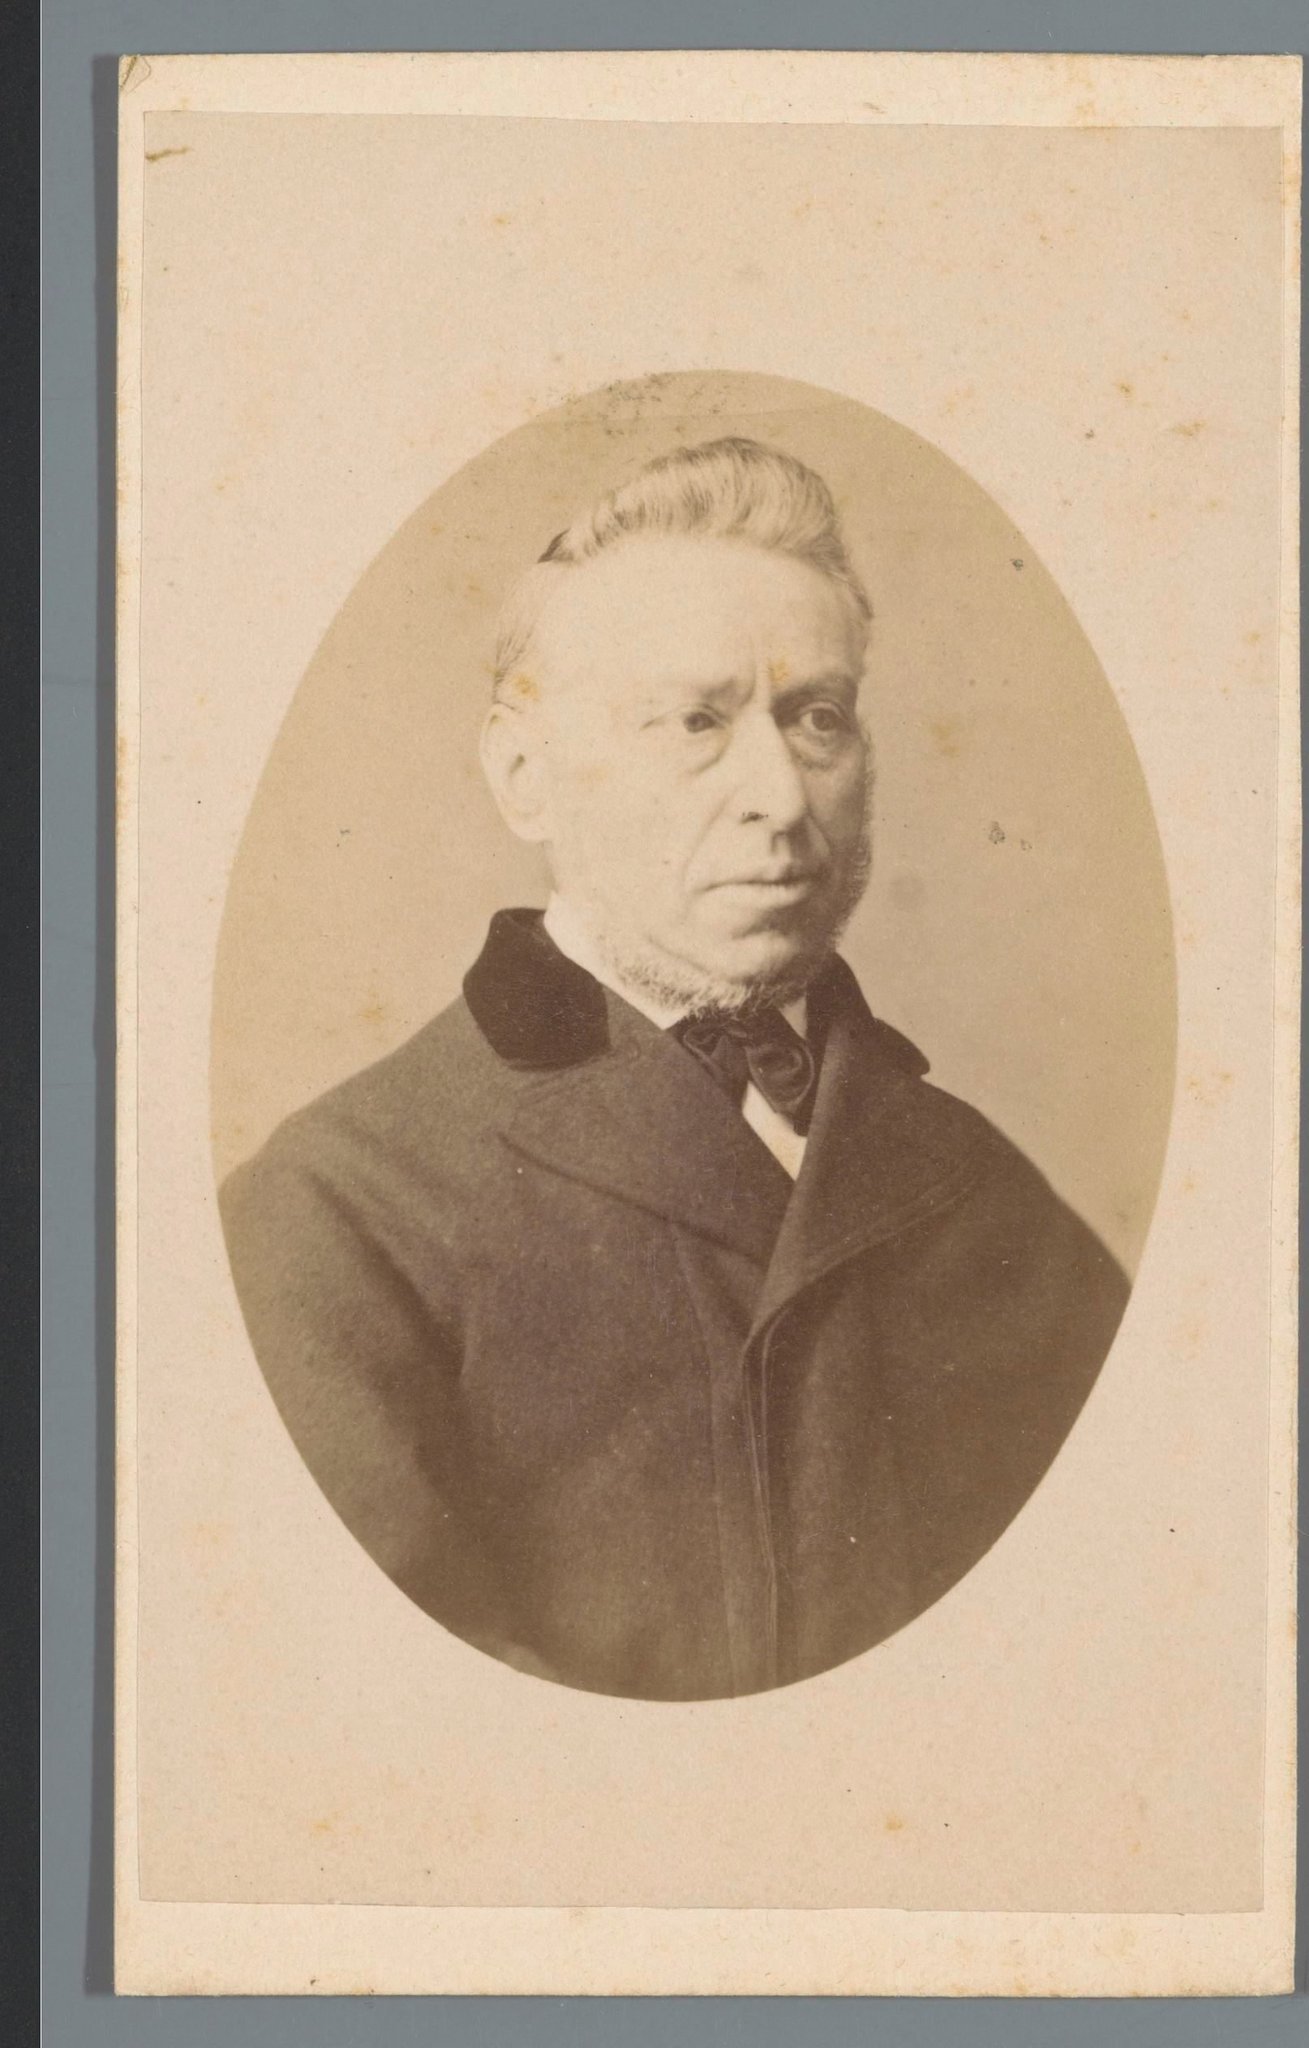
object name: carte de visite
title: Portret van een onbekende man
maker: dirk le grand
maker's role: artist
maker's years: 1819-1891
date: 1870-1891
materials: cardboard, paper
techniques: albumen print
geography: amsterdam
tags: adult man, historical persons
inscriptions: inscription: ‘le Grand’